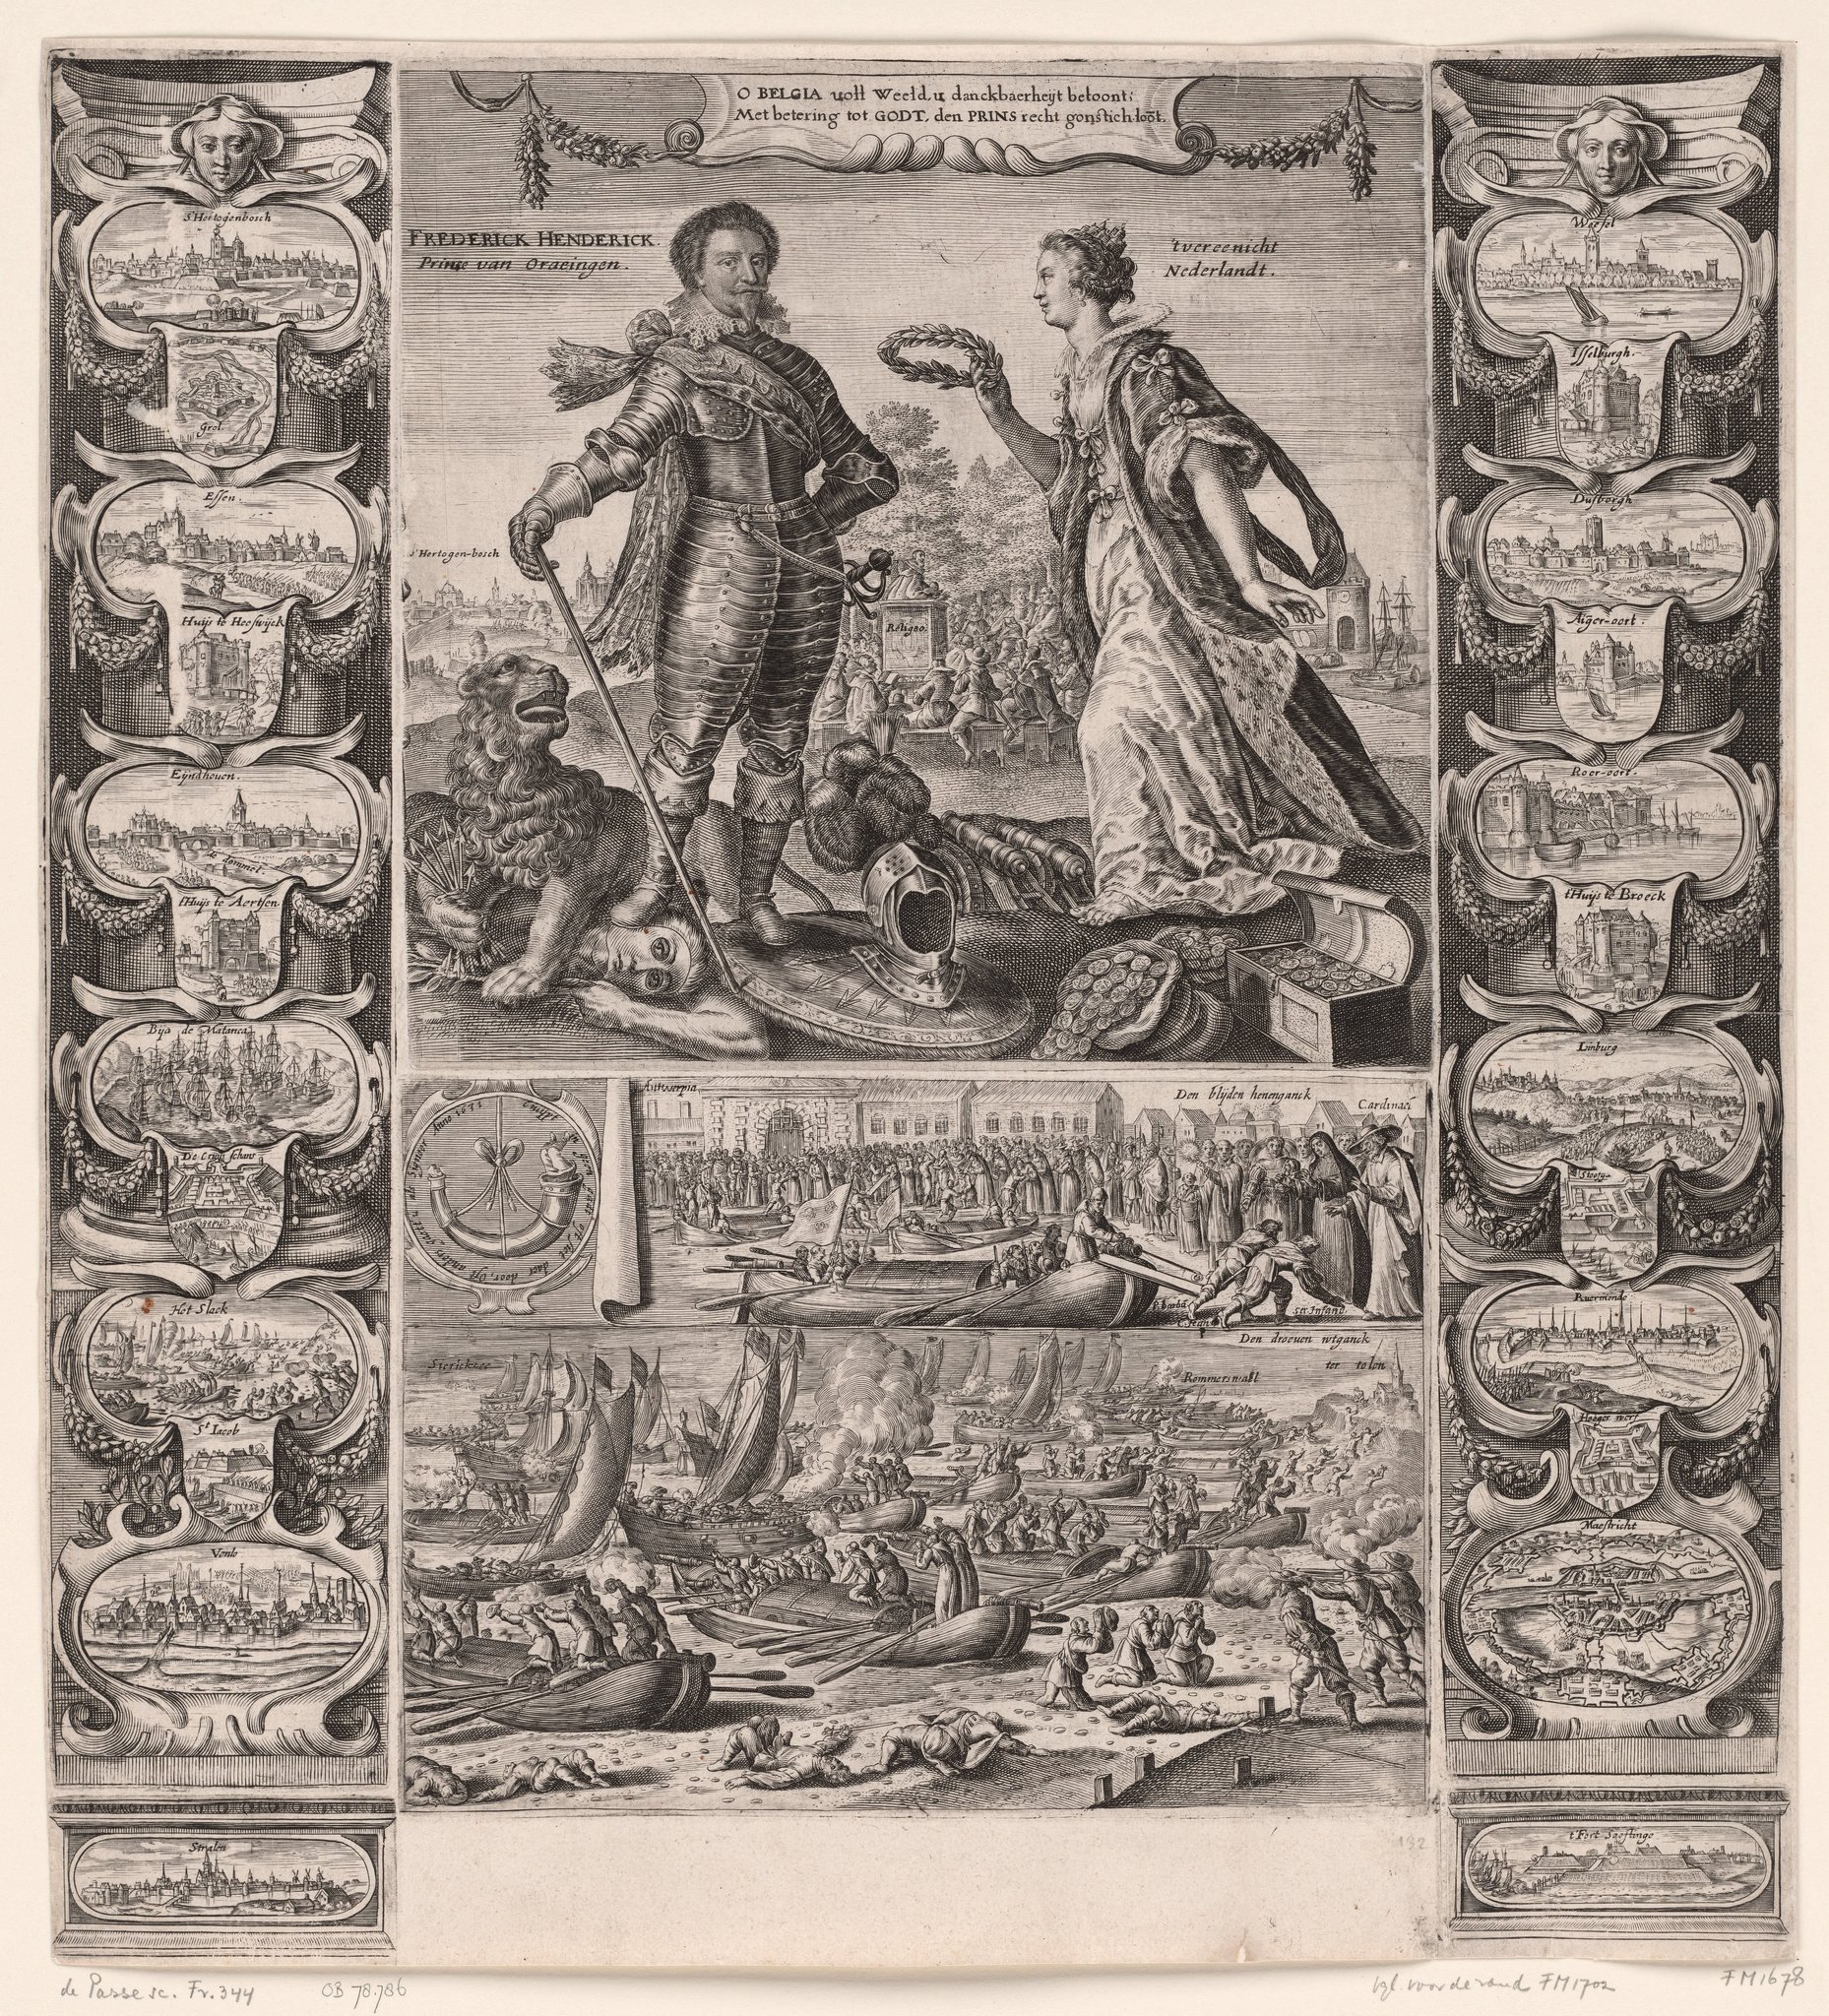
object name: print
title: Allegorie met Frederik Hendrik en de overwinning op de Spanjaarden op het Slaak, 1632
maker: crispijn van de passe (ii)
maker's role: draughtsman, print maker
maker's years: 1594-1670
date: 1632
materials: paper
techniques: engraving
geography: northern netherlands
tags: delft, frederick henry (prince of orange), infante van spanje isabella clara eugenia, albert de ligne (prins van barbançon en arenberg), prayer or religious service before battle, massacre ~ war, antwerp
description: Allegorie met stadhouder Frederik Hendrik en de overwinning op de Spanjaarden op het Slaak, 12-13 september 1631. De Staatse vloot stond onder bevel van vice-admiraal Marinus Hollare. Blad samengesteld uit zes platen. Plaat middenboven: Frederik Hendrik staand tegenover personificatie van de verenigde Nederlanden (vrouw die hem een lauwerkrans aanreikt). Op de achtergrond Religio: mensen luisterend naar een preek. Op de grond vergaarde rijkdommen, wapentuig en de Nederlandse Leeuw. Op de achtergrond Den Bosch (veroverd in 1629). Aan weerszijden twee platen met veroverde steden en overwinningen tussen 1629 en 1632. Onderaan aan elke zijde een kleine plaat als voetstuk. Plaat middenonder: begin van de expeditie te Antwerpen en ongelukkig eind tijdens de slag op het Slaak.